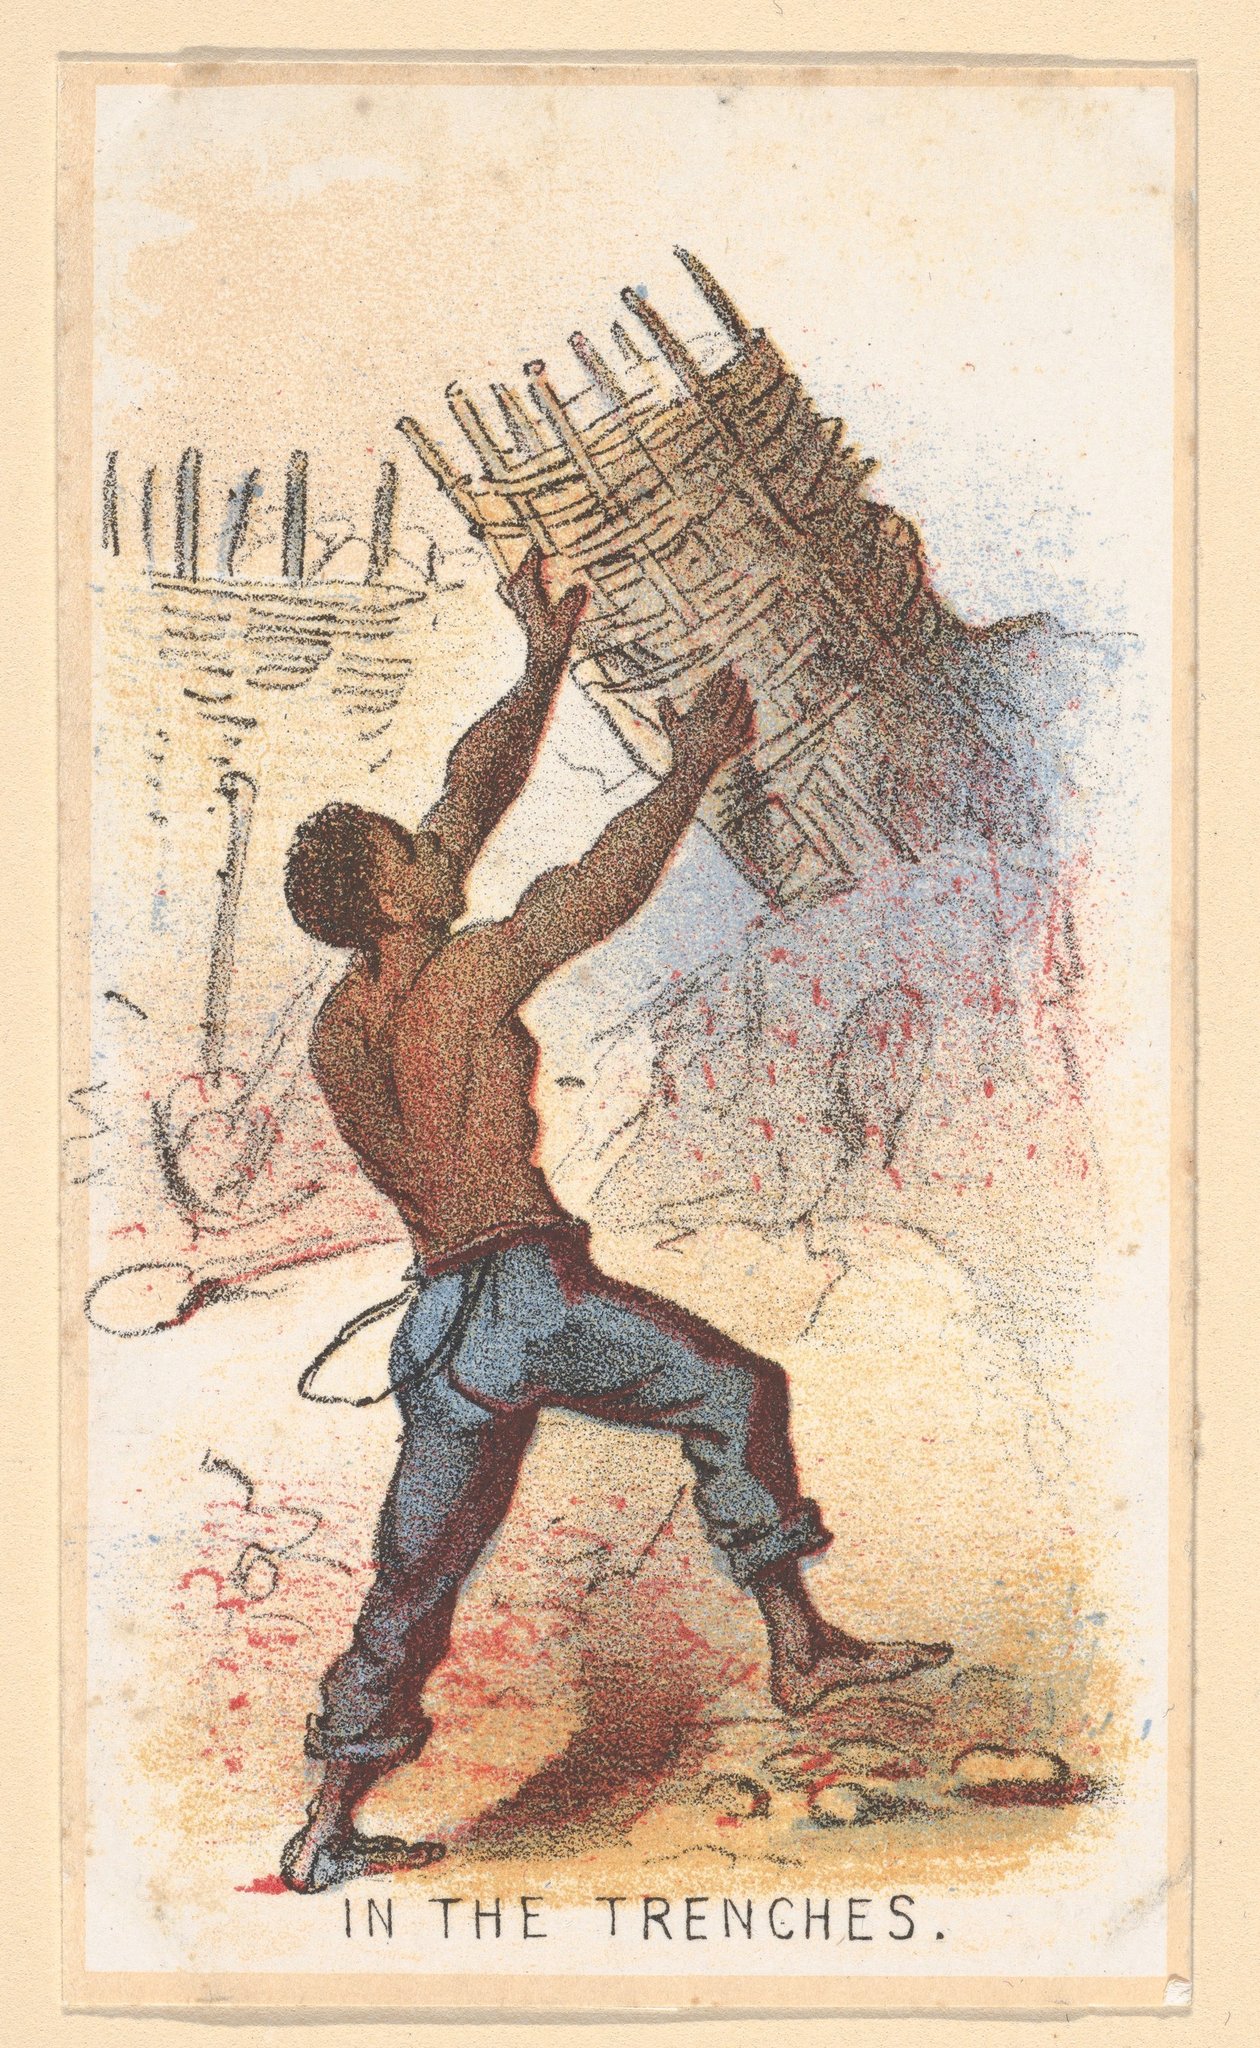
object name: print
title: Life in Camp, Part 2: In the Trenches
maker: winslow homer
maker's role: artist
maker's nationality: american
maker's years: 1836-1910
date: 1864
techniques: lithograph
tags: american civil war,men,working